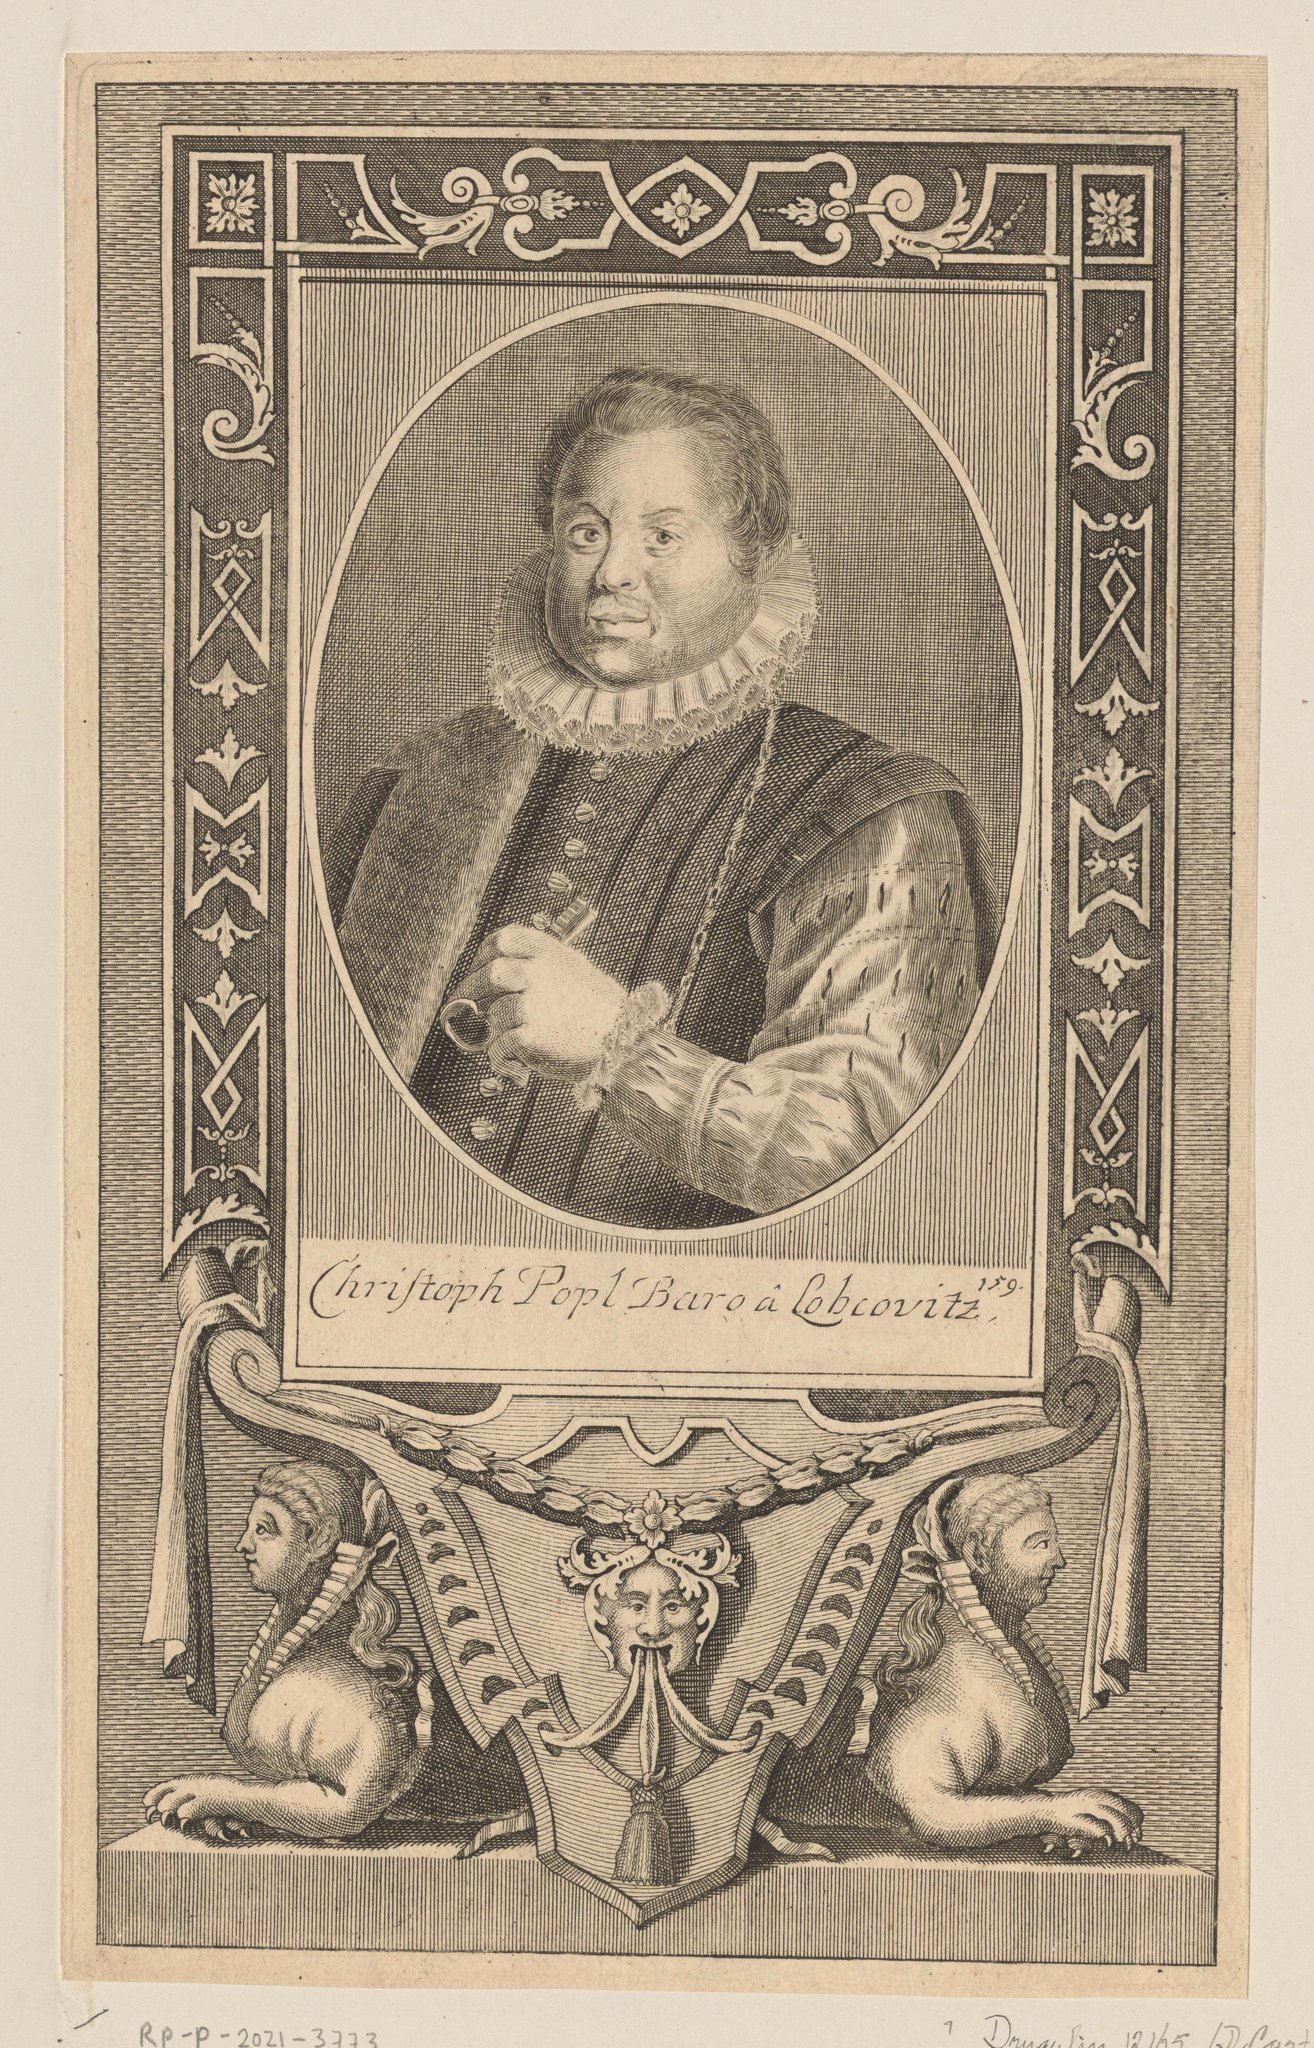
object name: book illustration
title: Portret van Christoph Popel baron van Lobkowicz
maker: johann friedrich rosbach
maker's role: print maker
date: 1722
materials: paper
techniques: engraving, etching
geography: germany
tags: christoph baron van lobkowitz popel, sphinx (lion/woman); 'sfinge' (ripa), ornament ~ medallion, historical persons, key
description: Prent met andere omlijsting gebruikt in: Khevenhüller, Franz Christoph. Conterfet Kupfferstich (...). Leipzig: Moritz Georg Weidmann, 1722, dl. 2. Deze prent komt waarschijnlijk uit een andere druk van het werk.